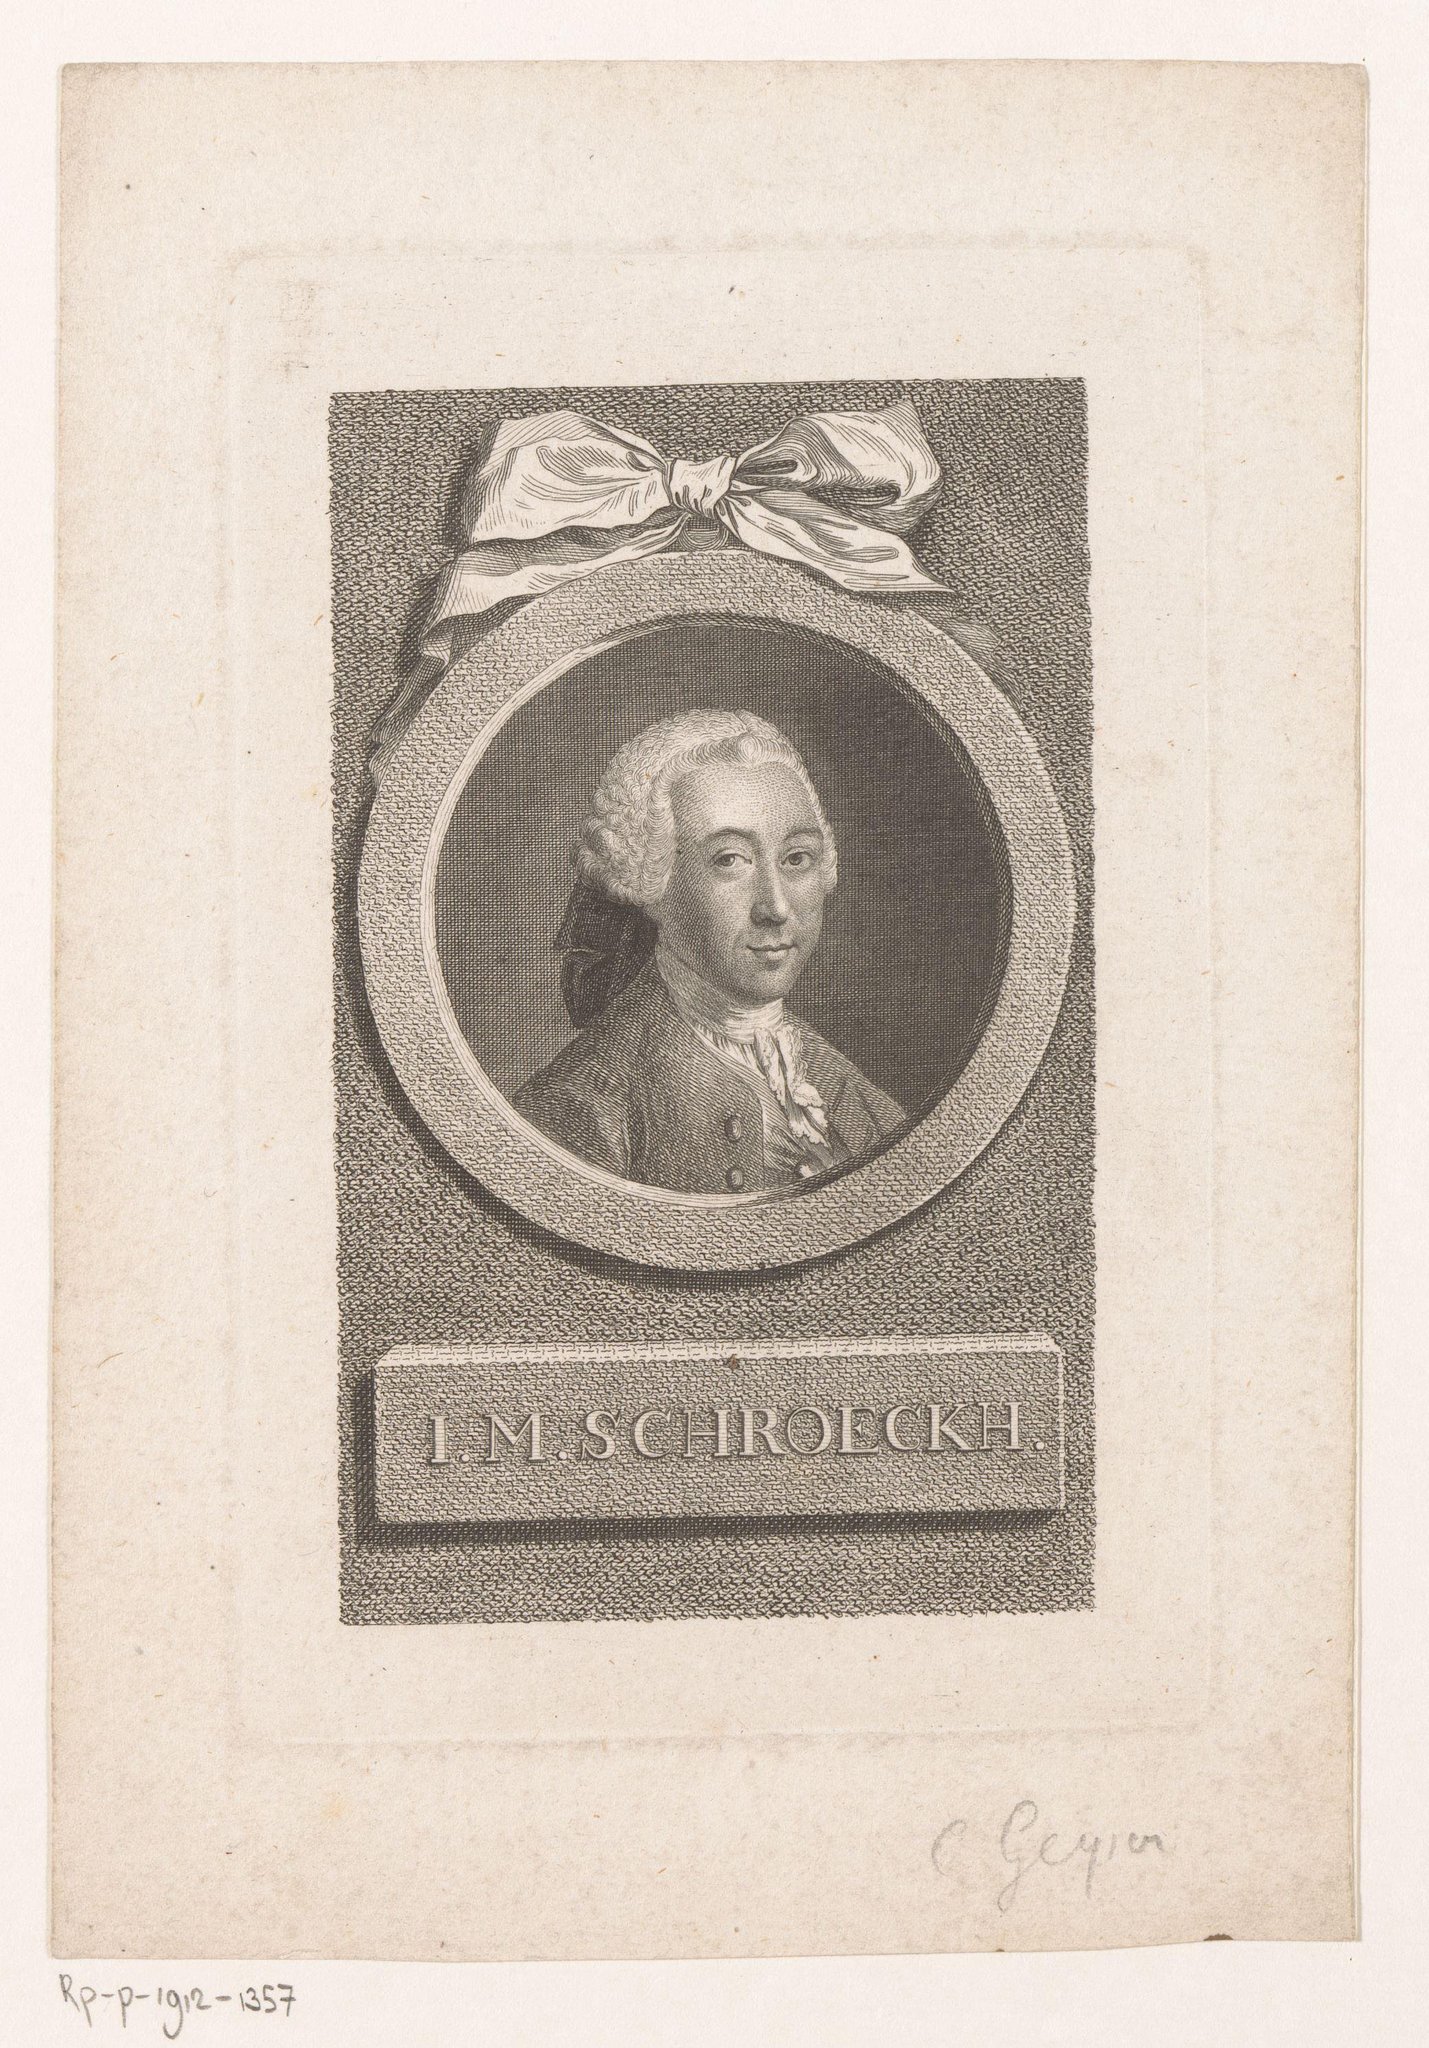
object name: print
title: Portret van Johann Matthias Schröckh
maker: christian gottlieb geyser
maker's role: print maker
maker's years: 1742-1803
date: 1752-1803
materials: paper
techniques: engraving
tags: vienna, ornament ~ medallion, historical persons, professor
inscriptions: collector's mark: Lugt 2228